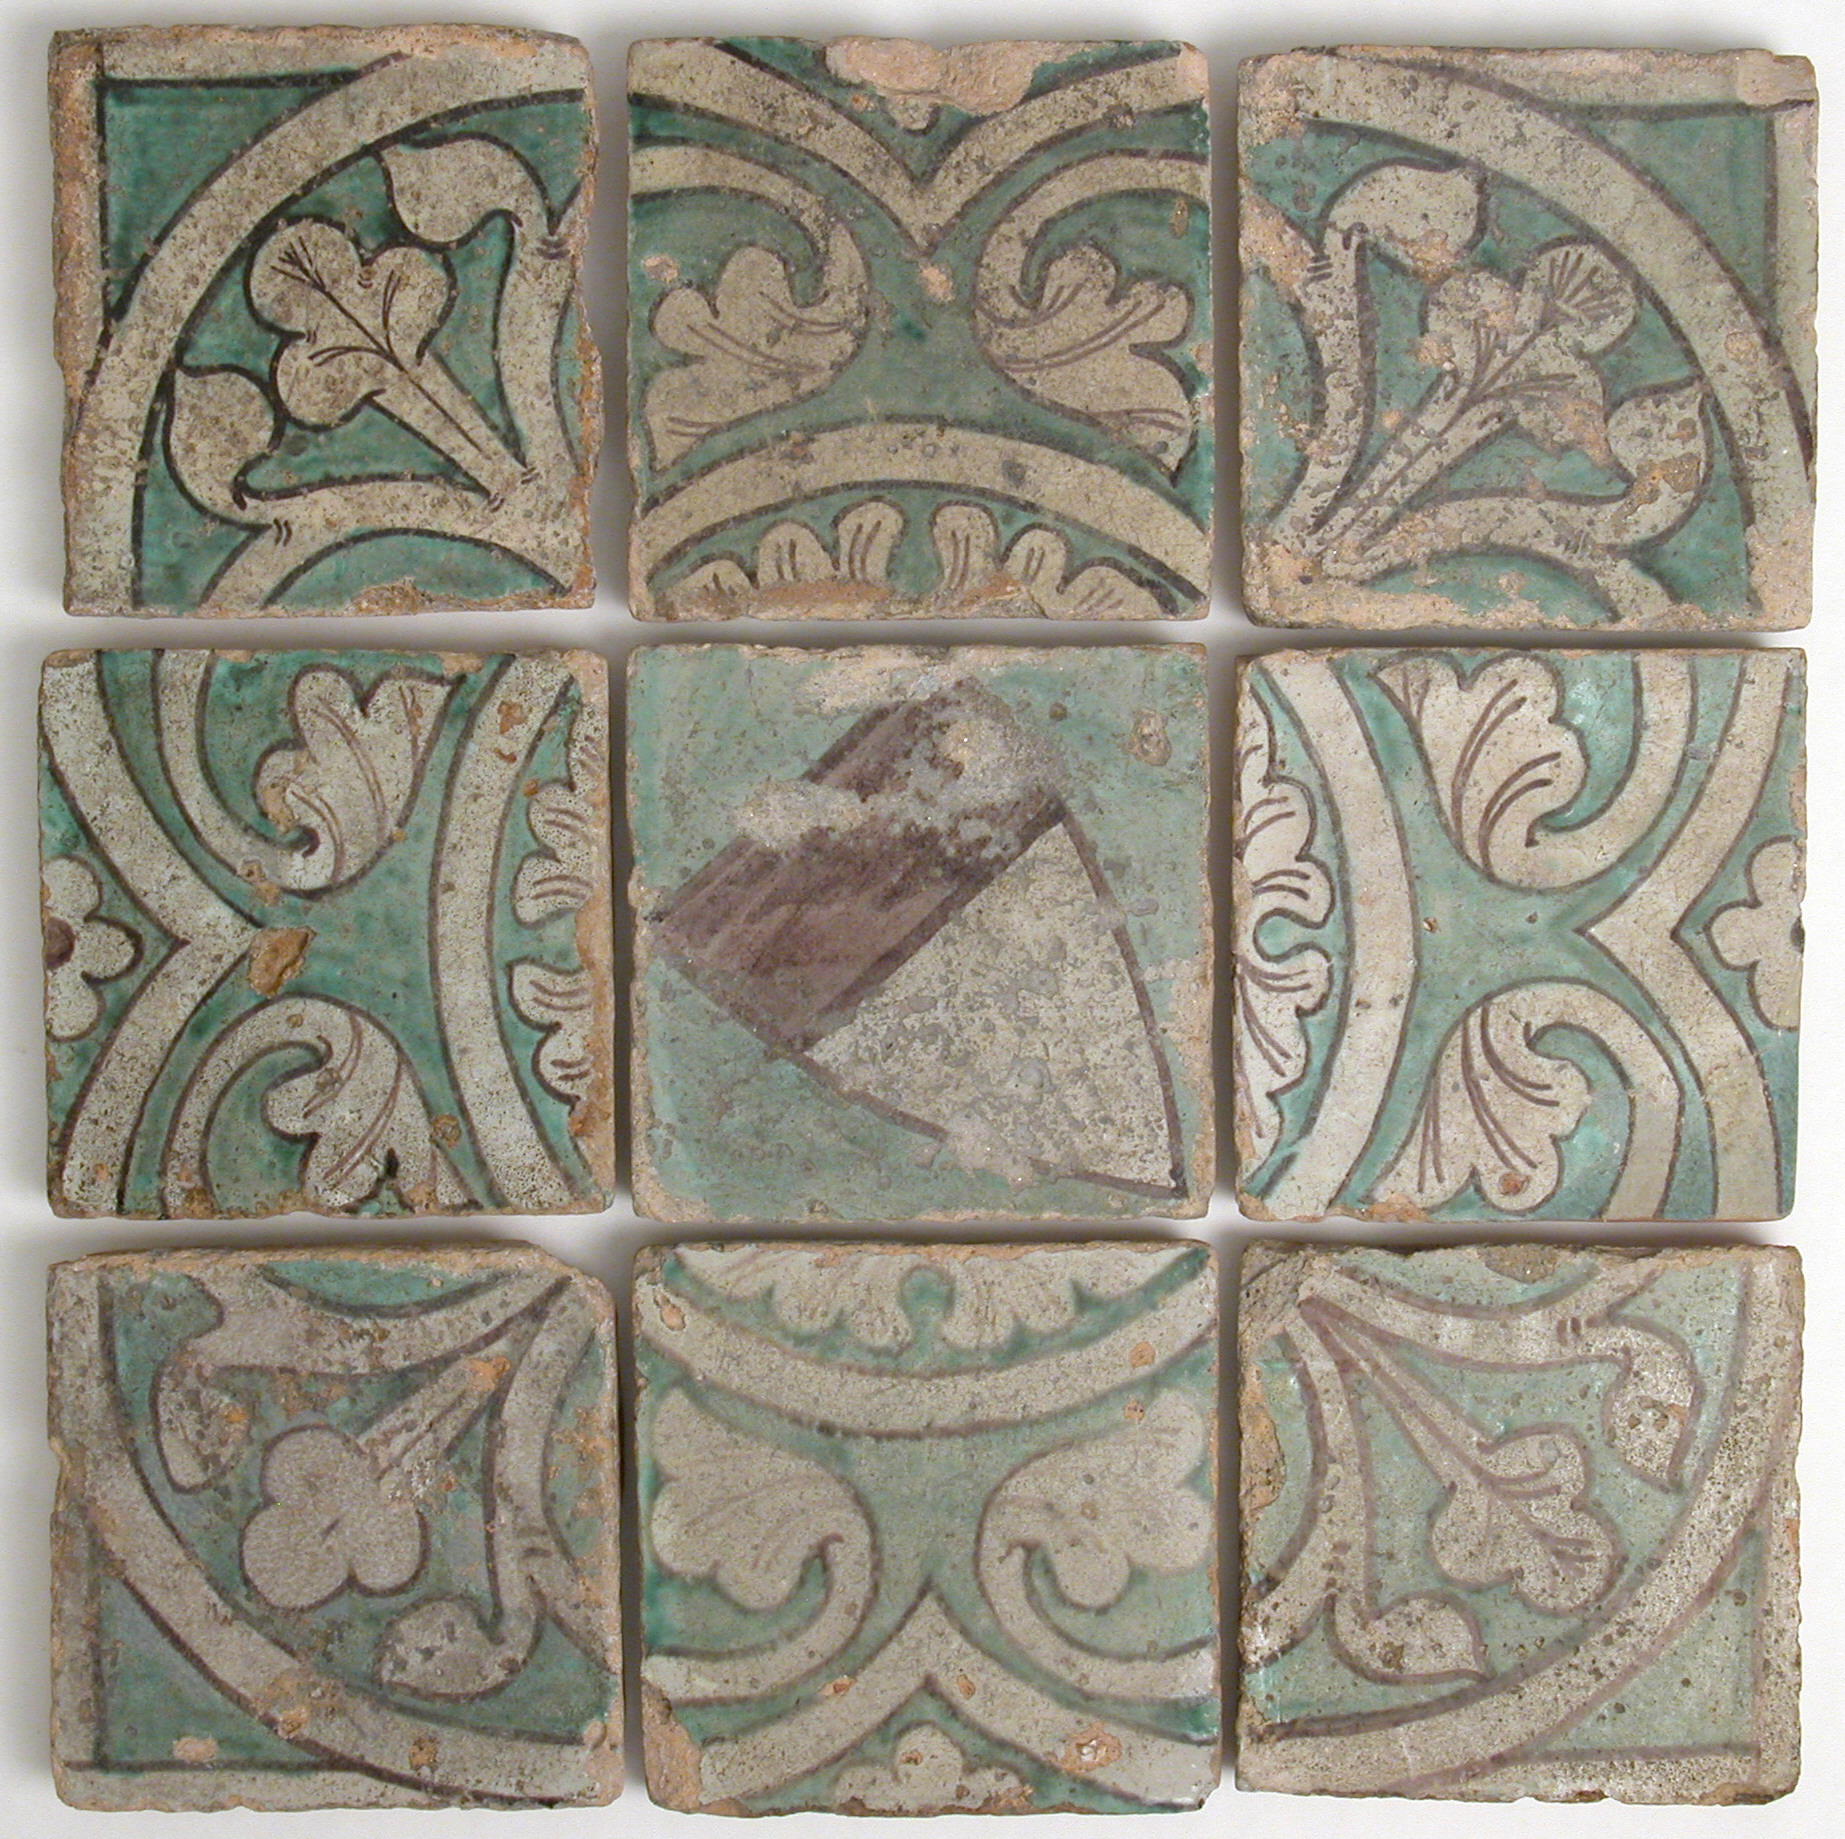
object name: tile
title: Nine Tiles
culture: french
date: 1301-1400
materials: earthenware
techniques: glazing